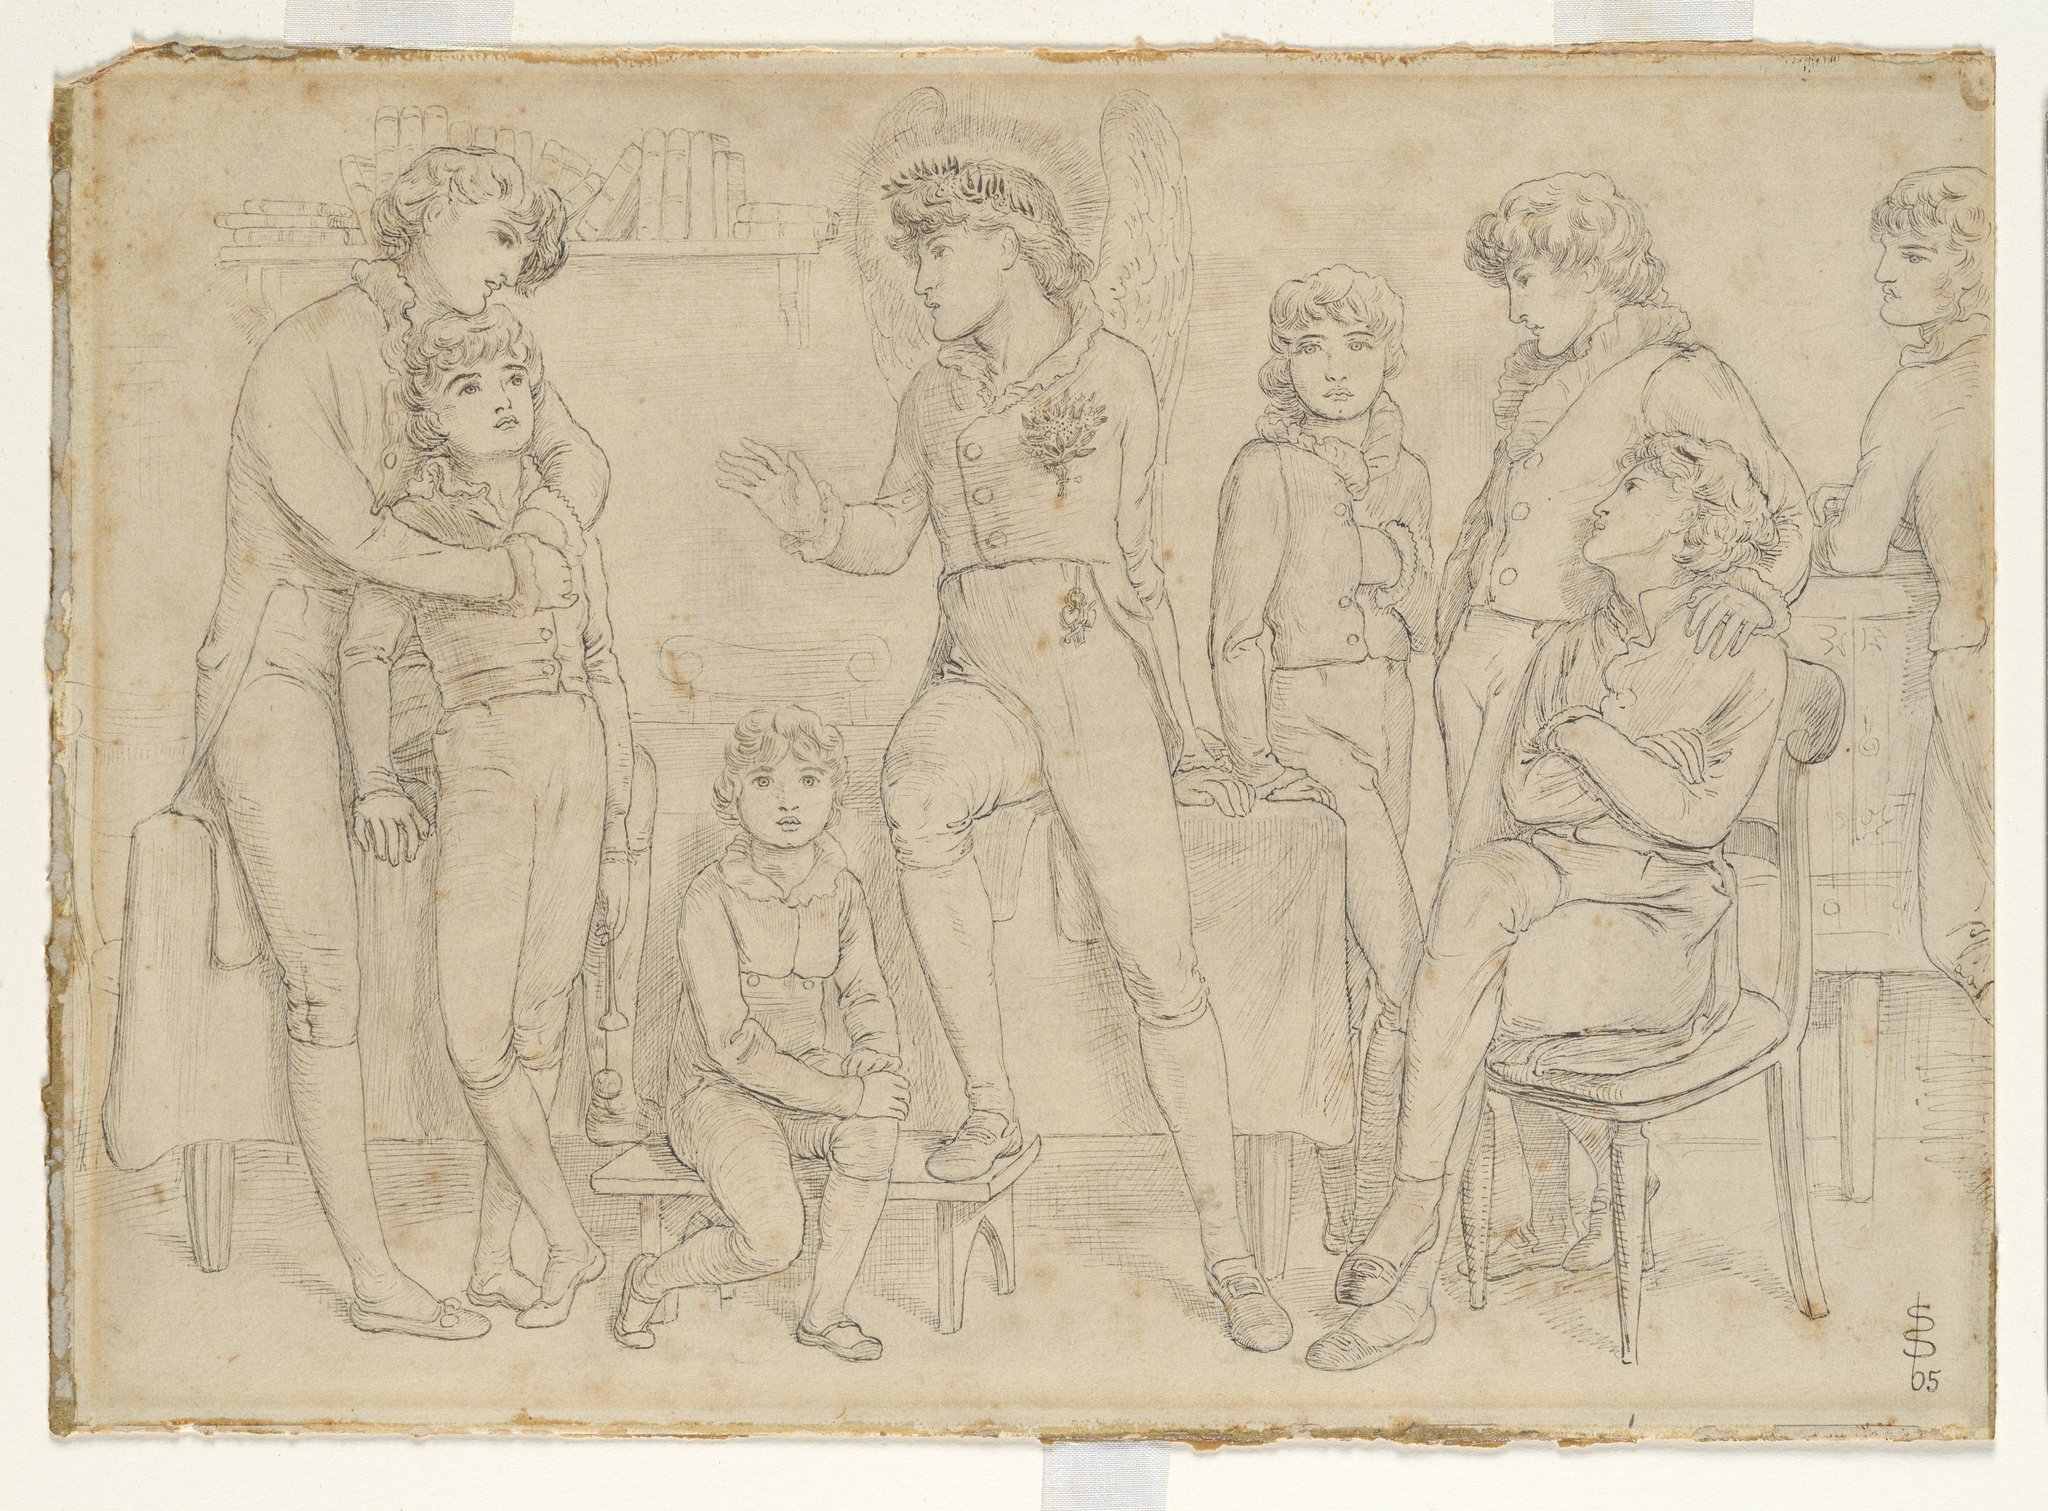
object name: drawing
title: Love Among the Schoolboys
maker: simeon solomon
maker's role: artist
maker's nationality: british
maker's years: 1840-1905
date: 1865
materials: graphite, ink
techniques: pen